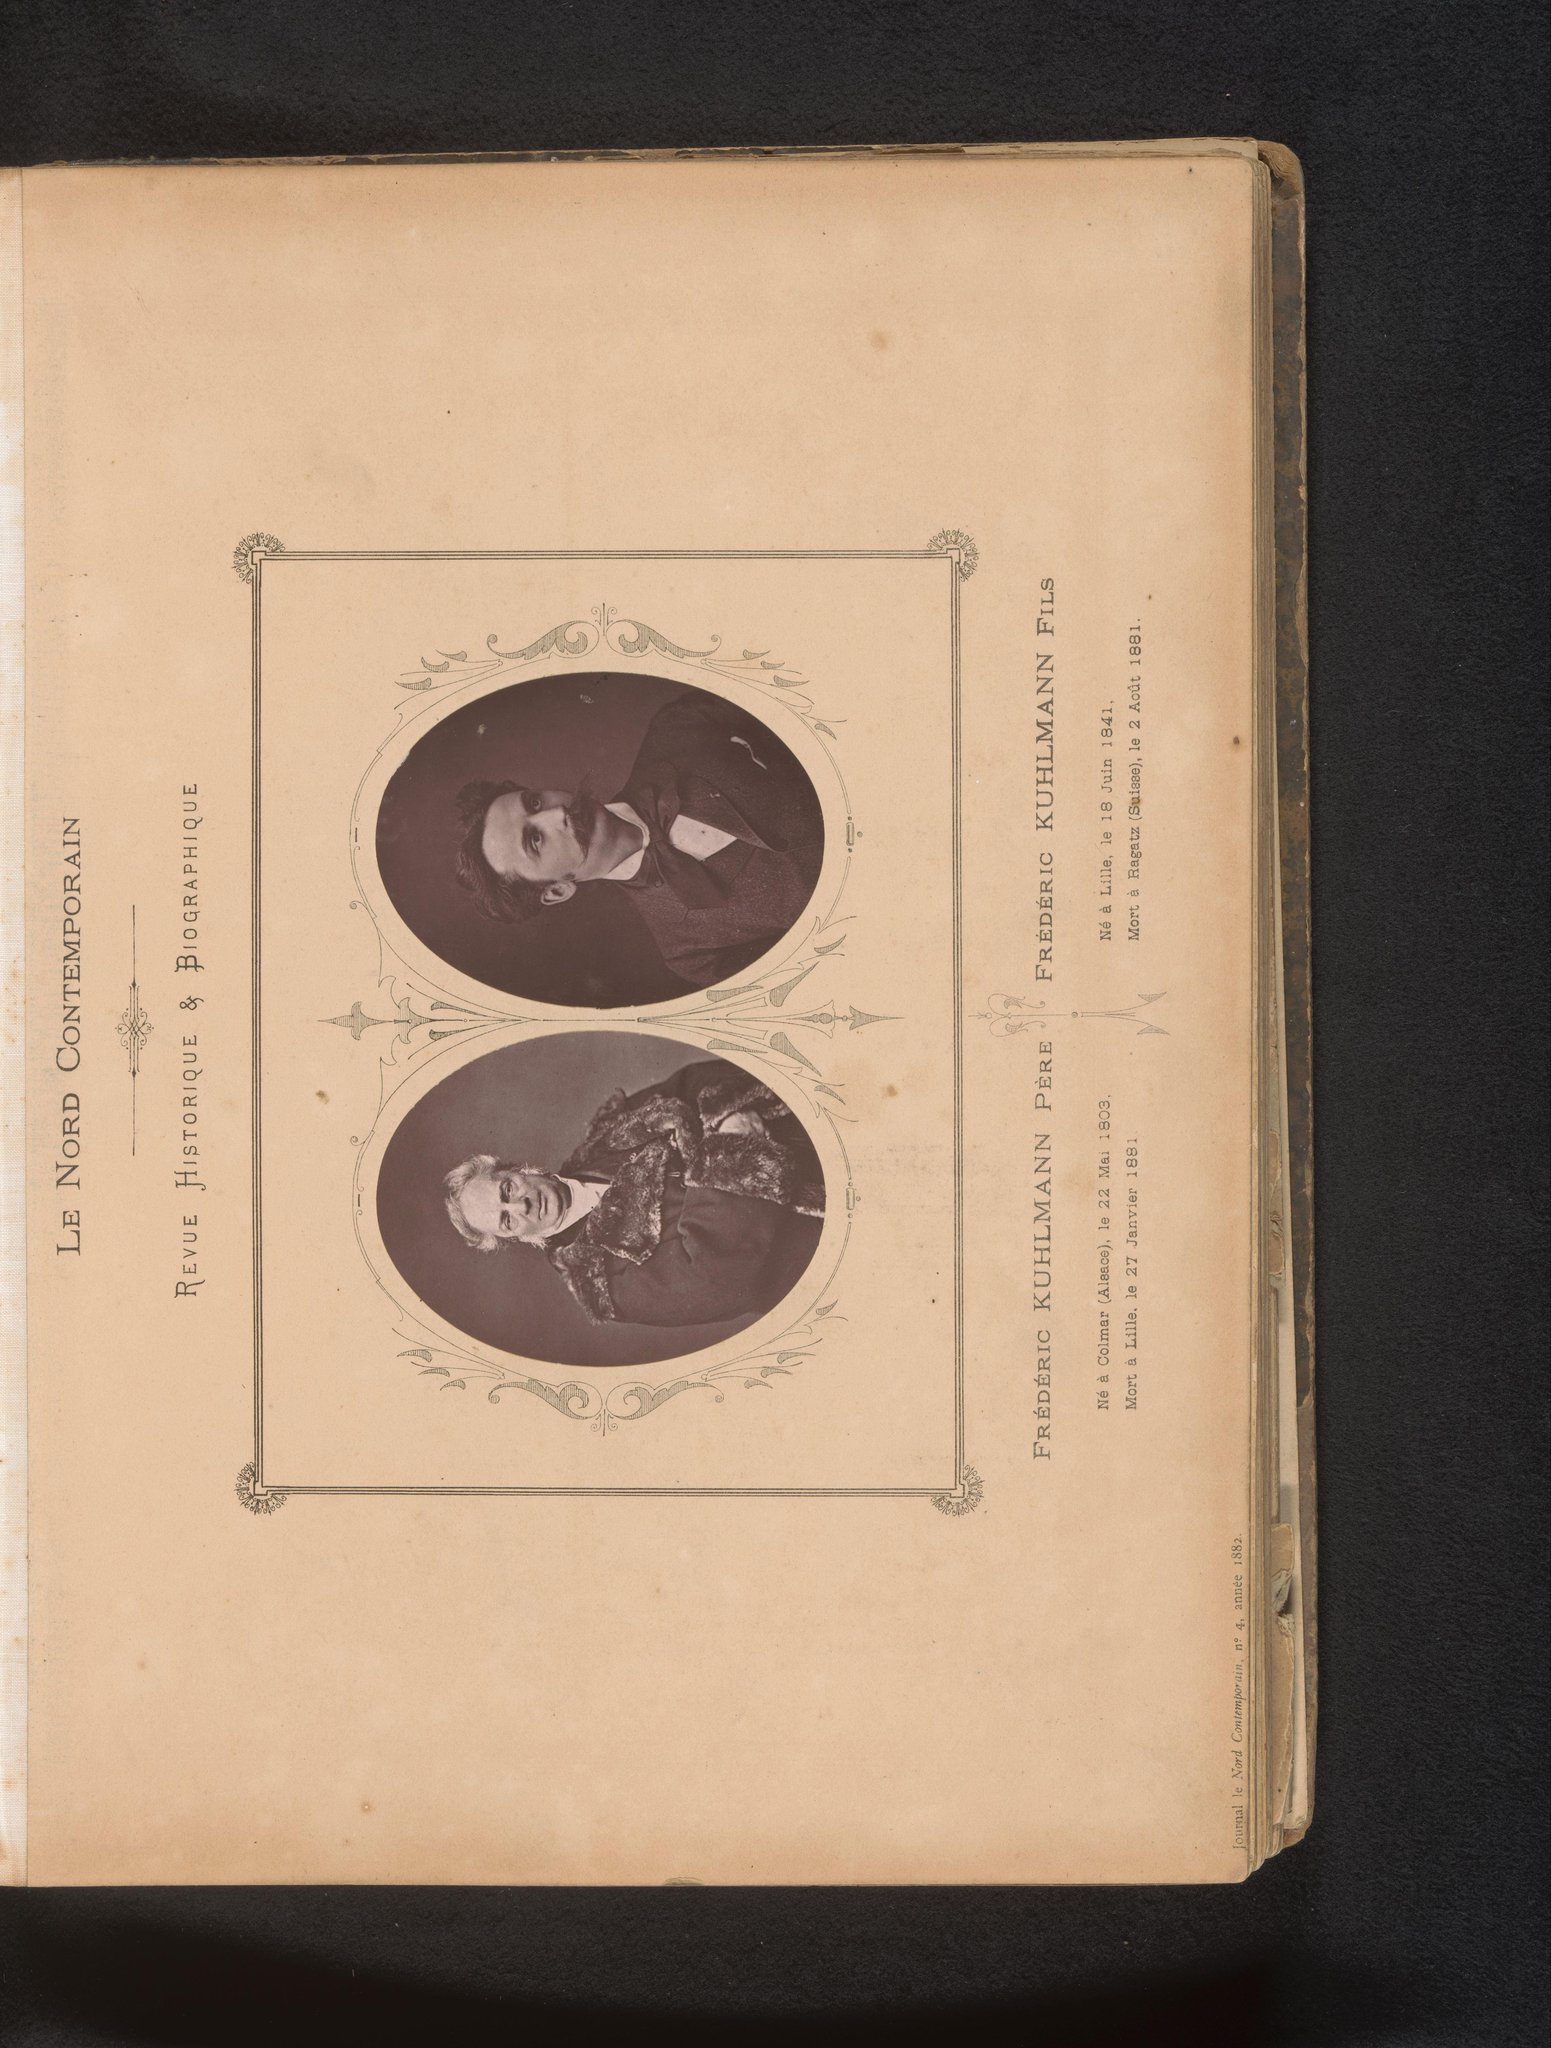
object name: photomechanical print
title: Frédéric Kuhlmann Père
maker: Anonymous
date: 1878-1882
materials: paper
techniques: woodburytype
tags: lille, historical persons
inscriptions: inscription: ‘Né à Colmar (Alsace), le 22 Mai 1803, Mort à Lille, le 27 Janvier 1881’, inscription: ‘Journal le Nord Contemporain, No 4, année 1882’, inscription: ‘Le Nord Contemporain/ Revue Historique & Biographique’